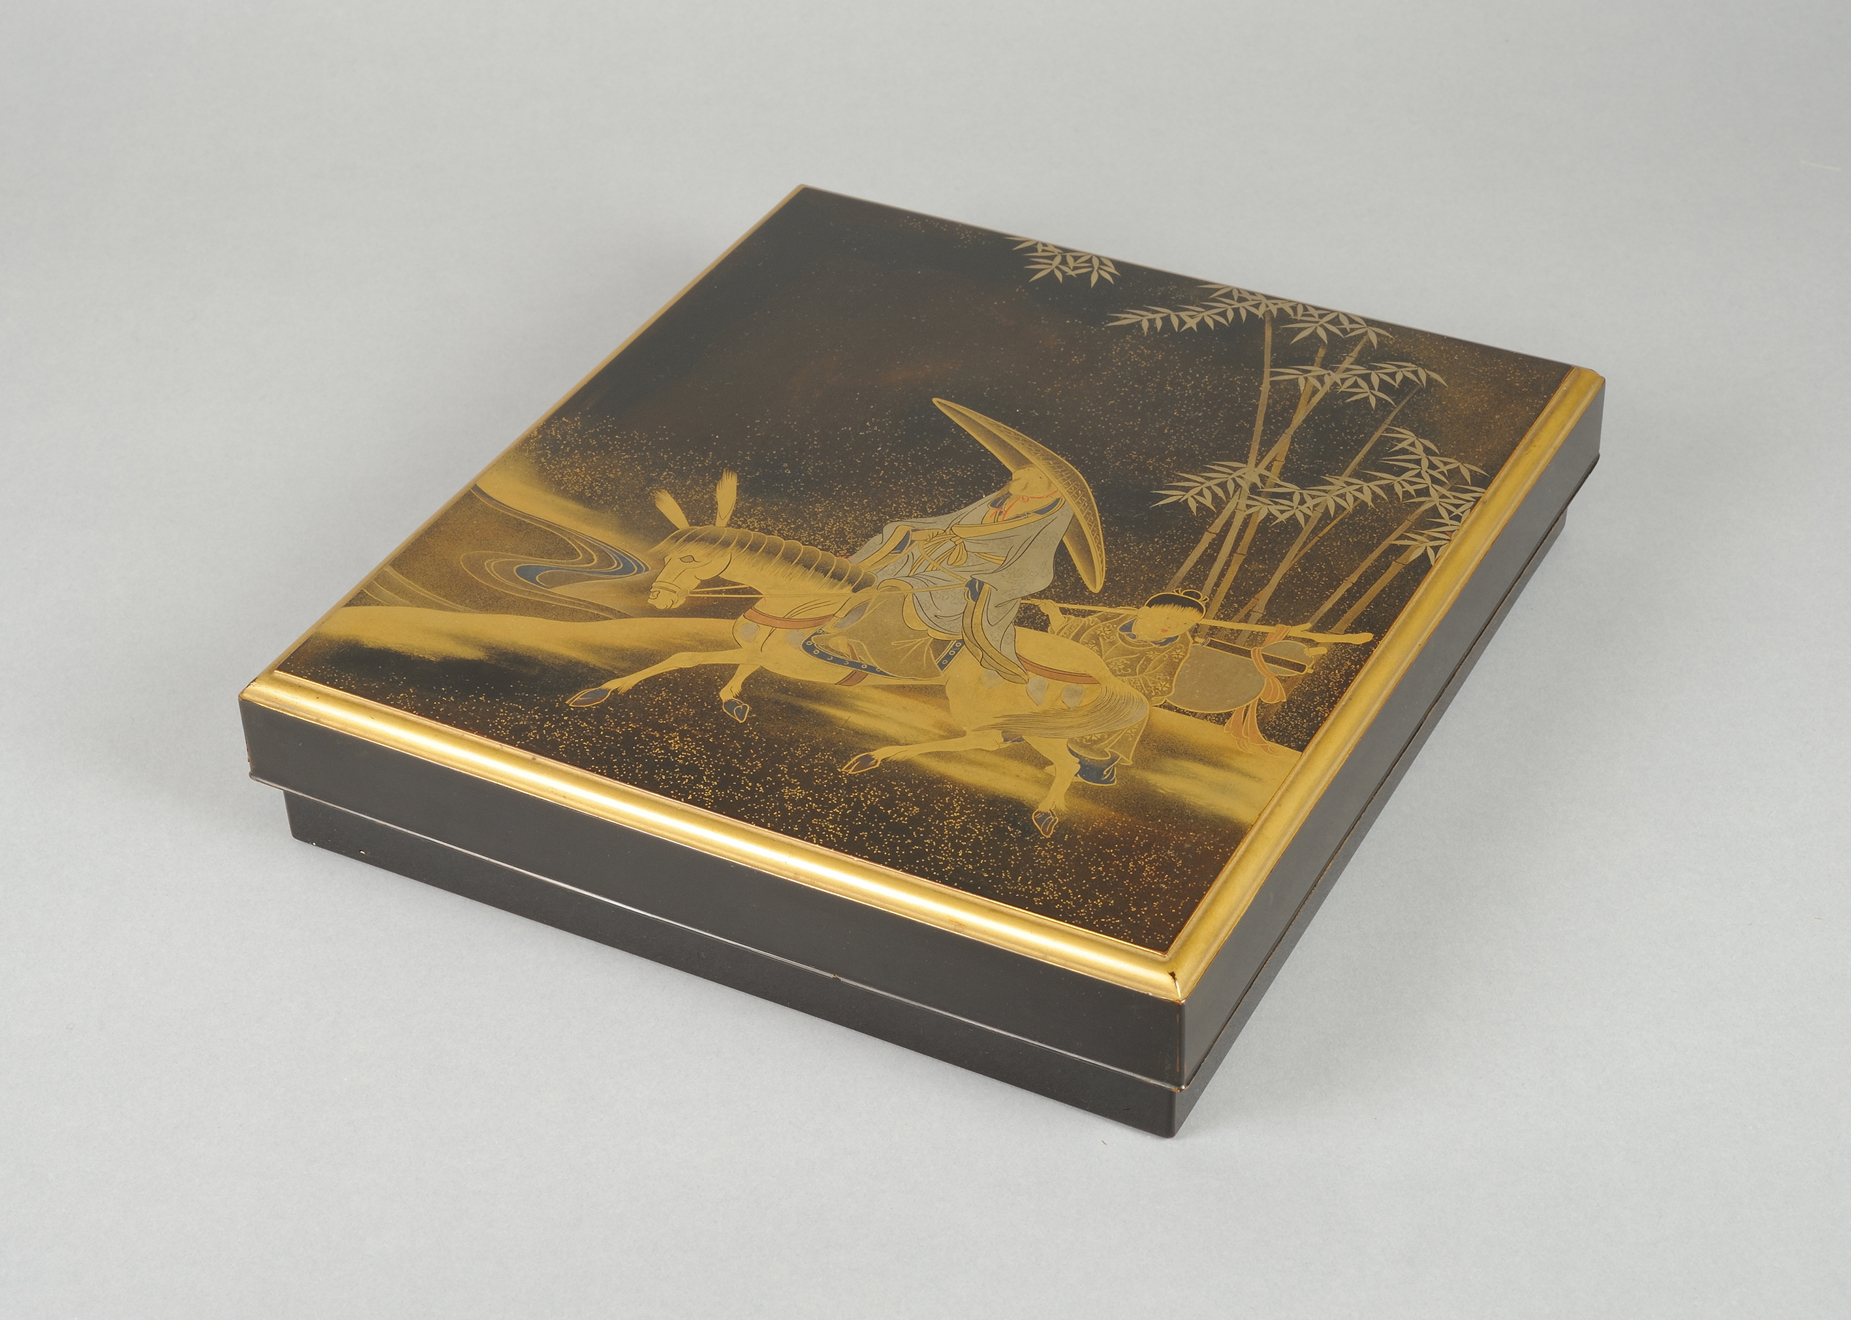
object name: writing box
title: Writing Box (Suzuribako) with Chinese Poet Su Dongpo and Attendant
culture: japanese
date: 1751-1800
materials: gold, silver, wood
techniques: lacquer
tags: men,donkeys